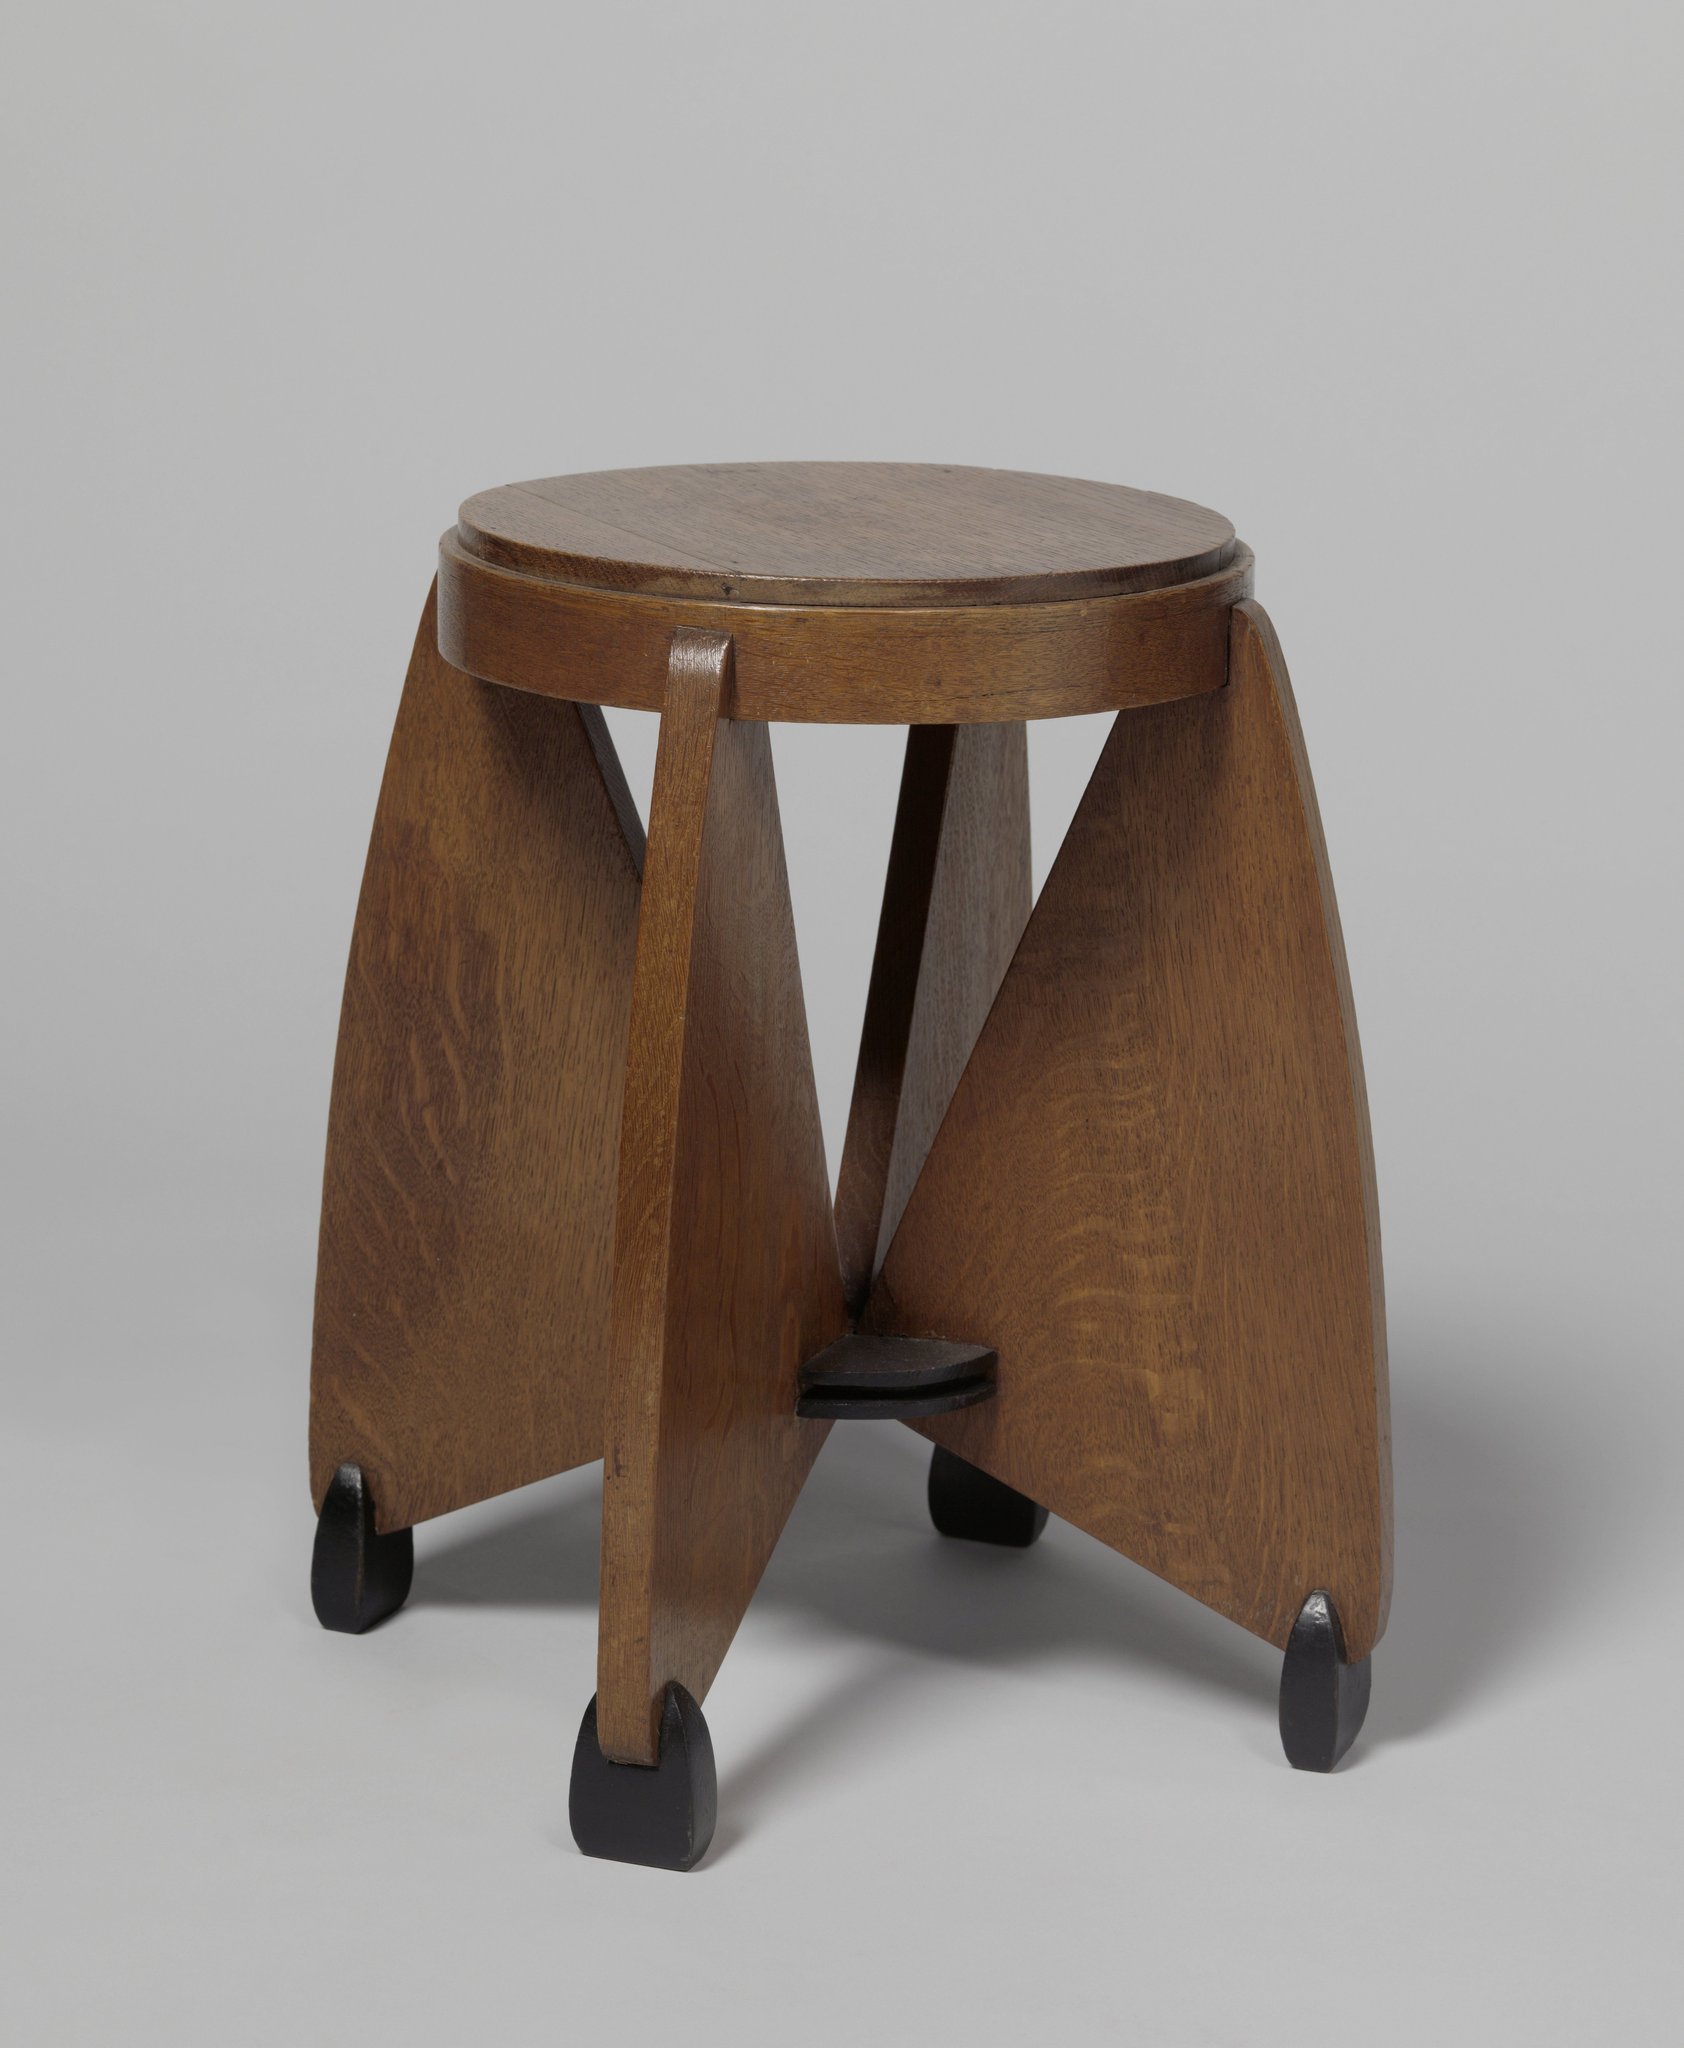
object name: suite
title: Tafel met rond tafelblad rustend op vier naar elkaar gerichte wanden gevat in klossen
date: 1920-1930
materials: wood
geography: netherlands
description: Tafel van eikenhout met rond tafelblad rustend op vier naar elkaar gerichte wanden die aan de voorzijde gebogen zijn en aan de achterzijde door middel van schuine zijden uitlopen in een punt. De wanden zijn aan de binnenzijde met de punten onderling verbonden door middel van twee boven elkaar liggende zwart gebeitste schijven en zijn aan de onderzijde gevat in zwart gebeitste klossen met gebogen kanten. Het ronde tafelblad is gevat in een opstaande platte rand.